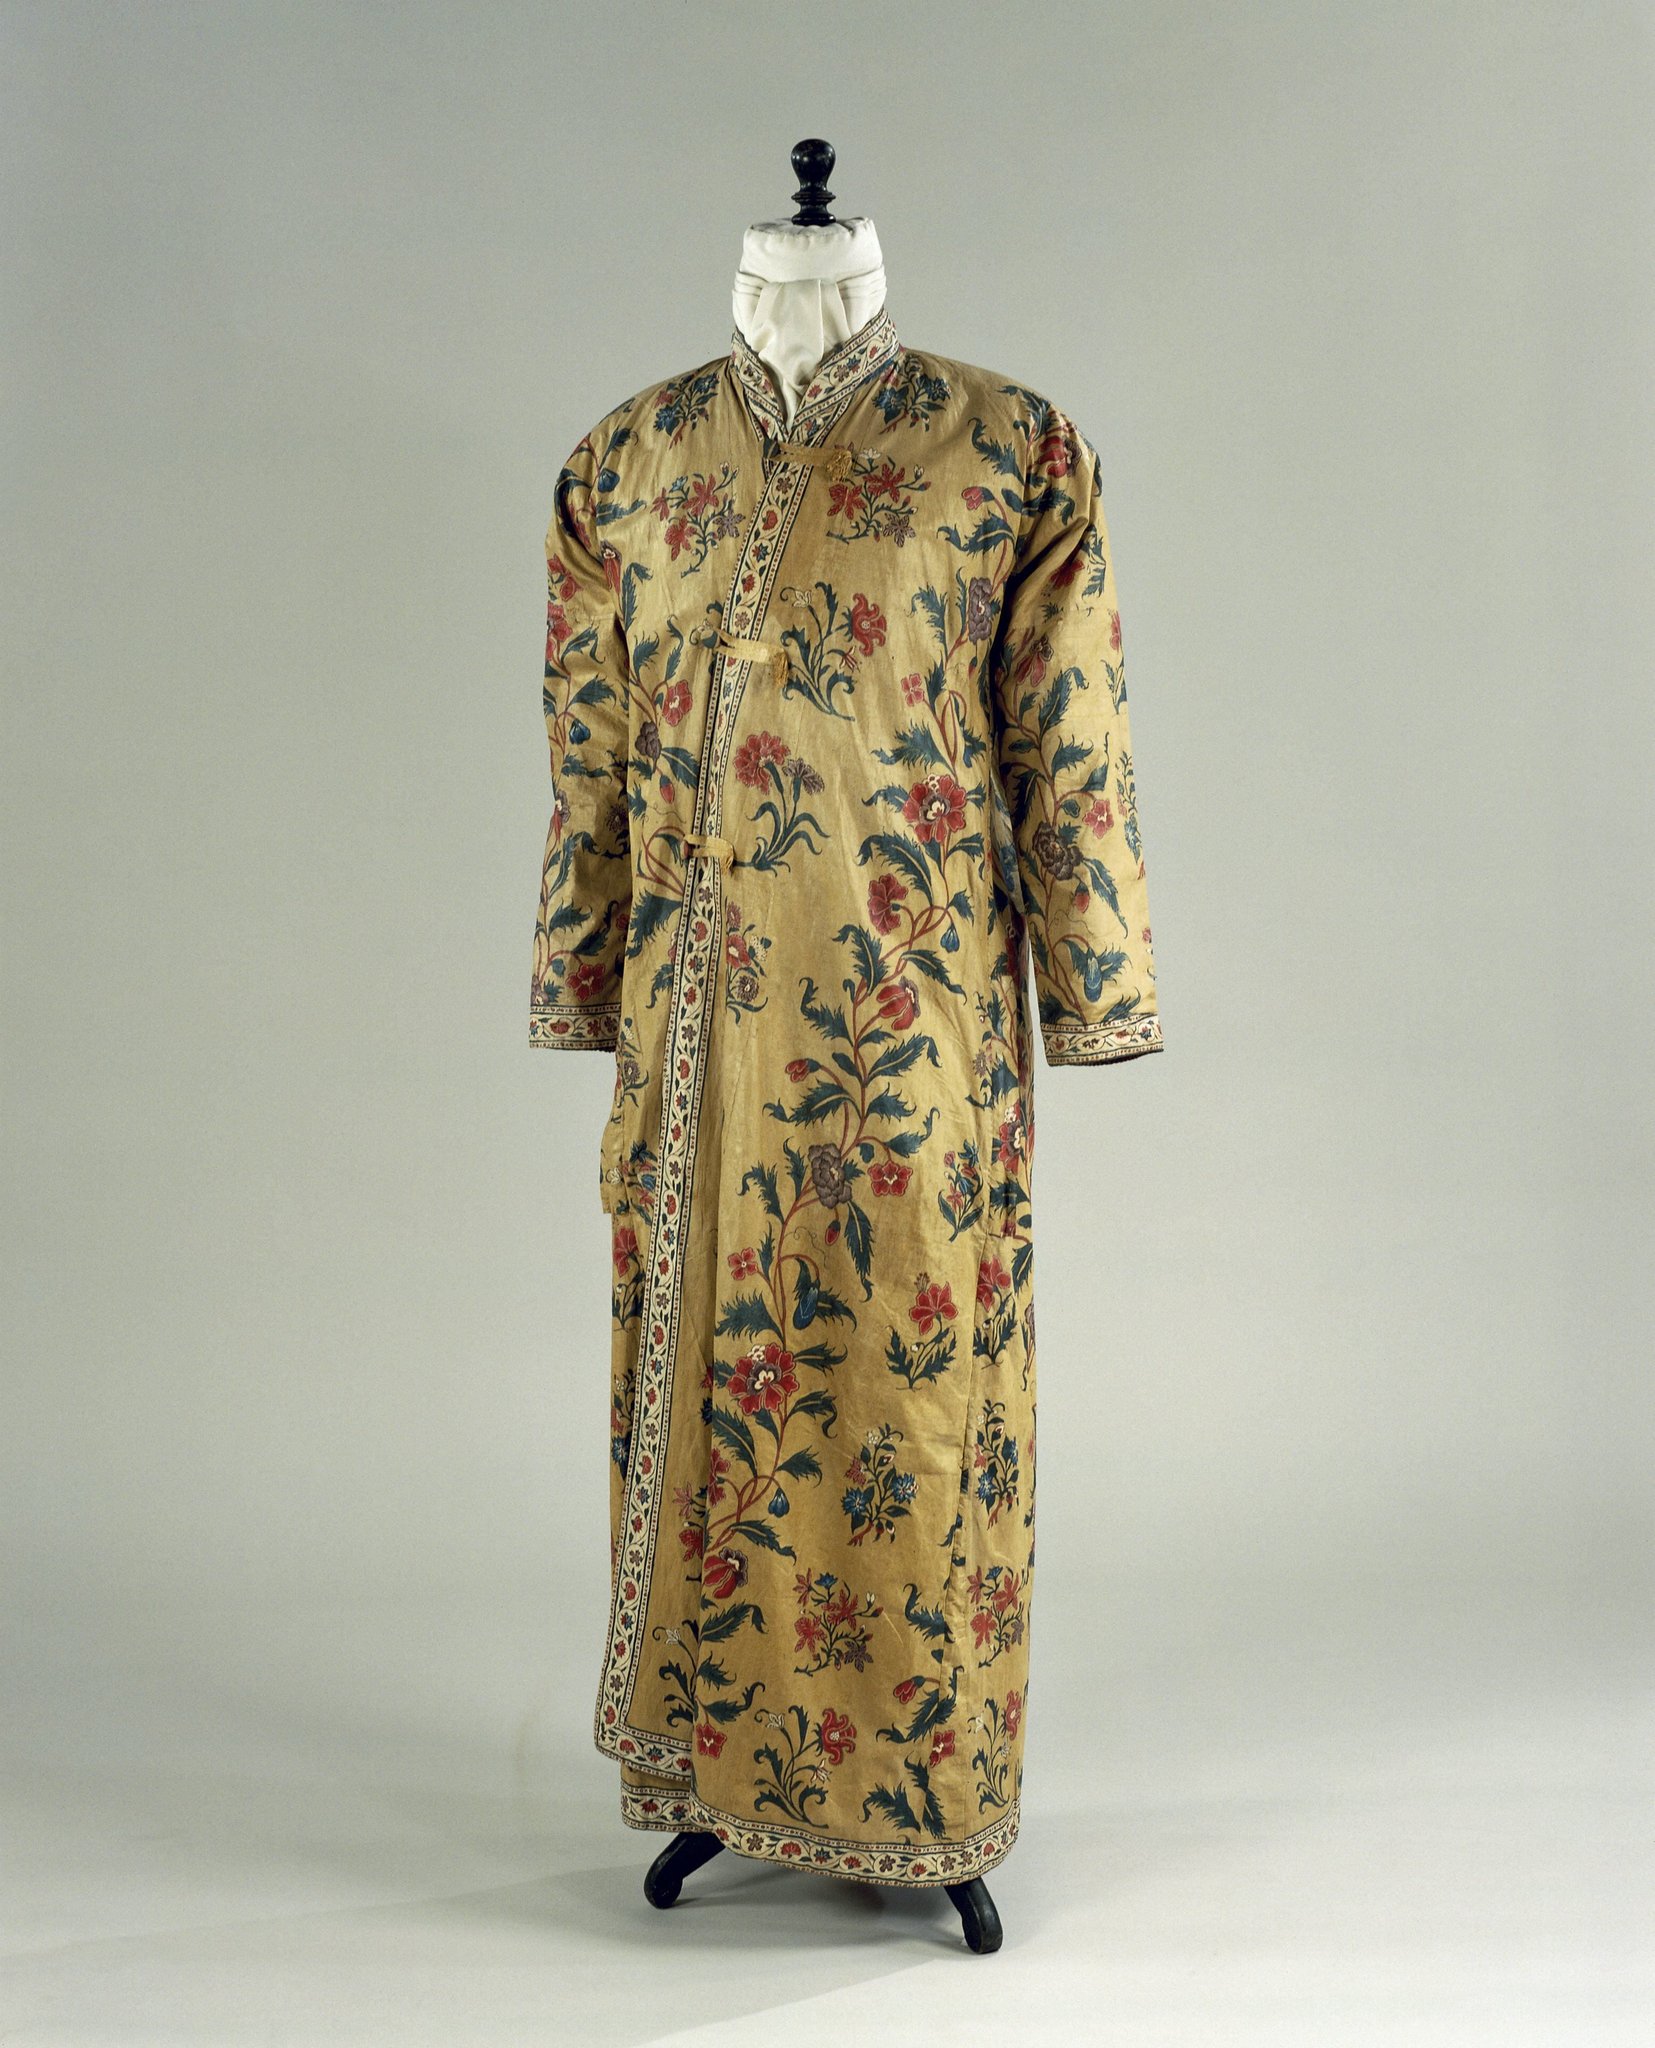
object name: menswear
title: Housecoat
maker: Anonymous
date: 1740-1760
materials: textile, cotton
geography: northwest india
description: The material used for this robe was most likely painted in North-West India. The colour scheme with the yellow ground and floral motifs is typical of this region. It has a braid-and-button cross-fastening. The lining, not visible here, is red cotton with white checks.